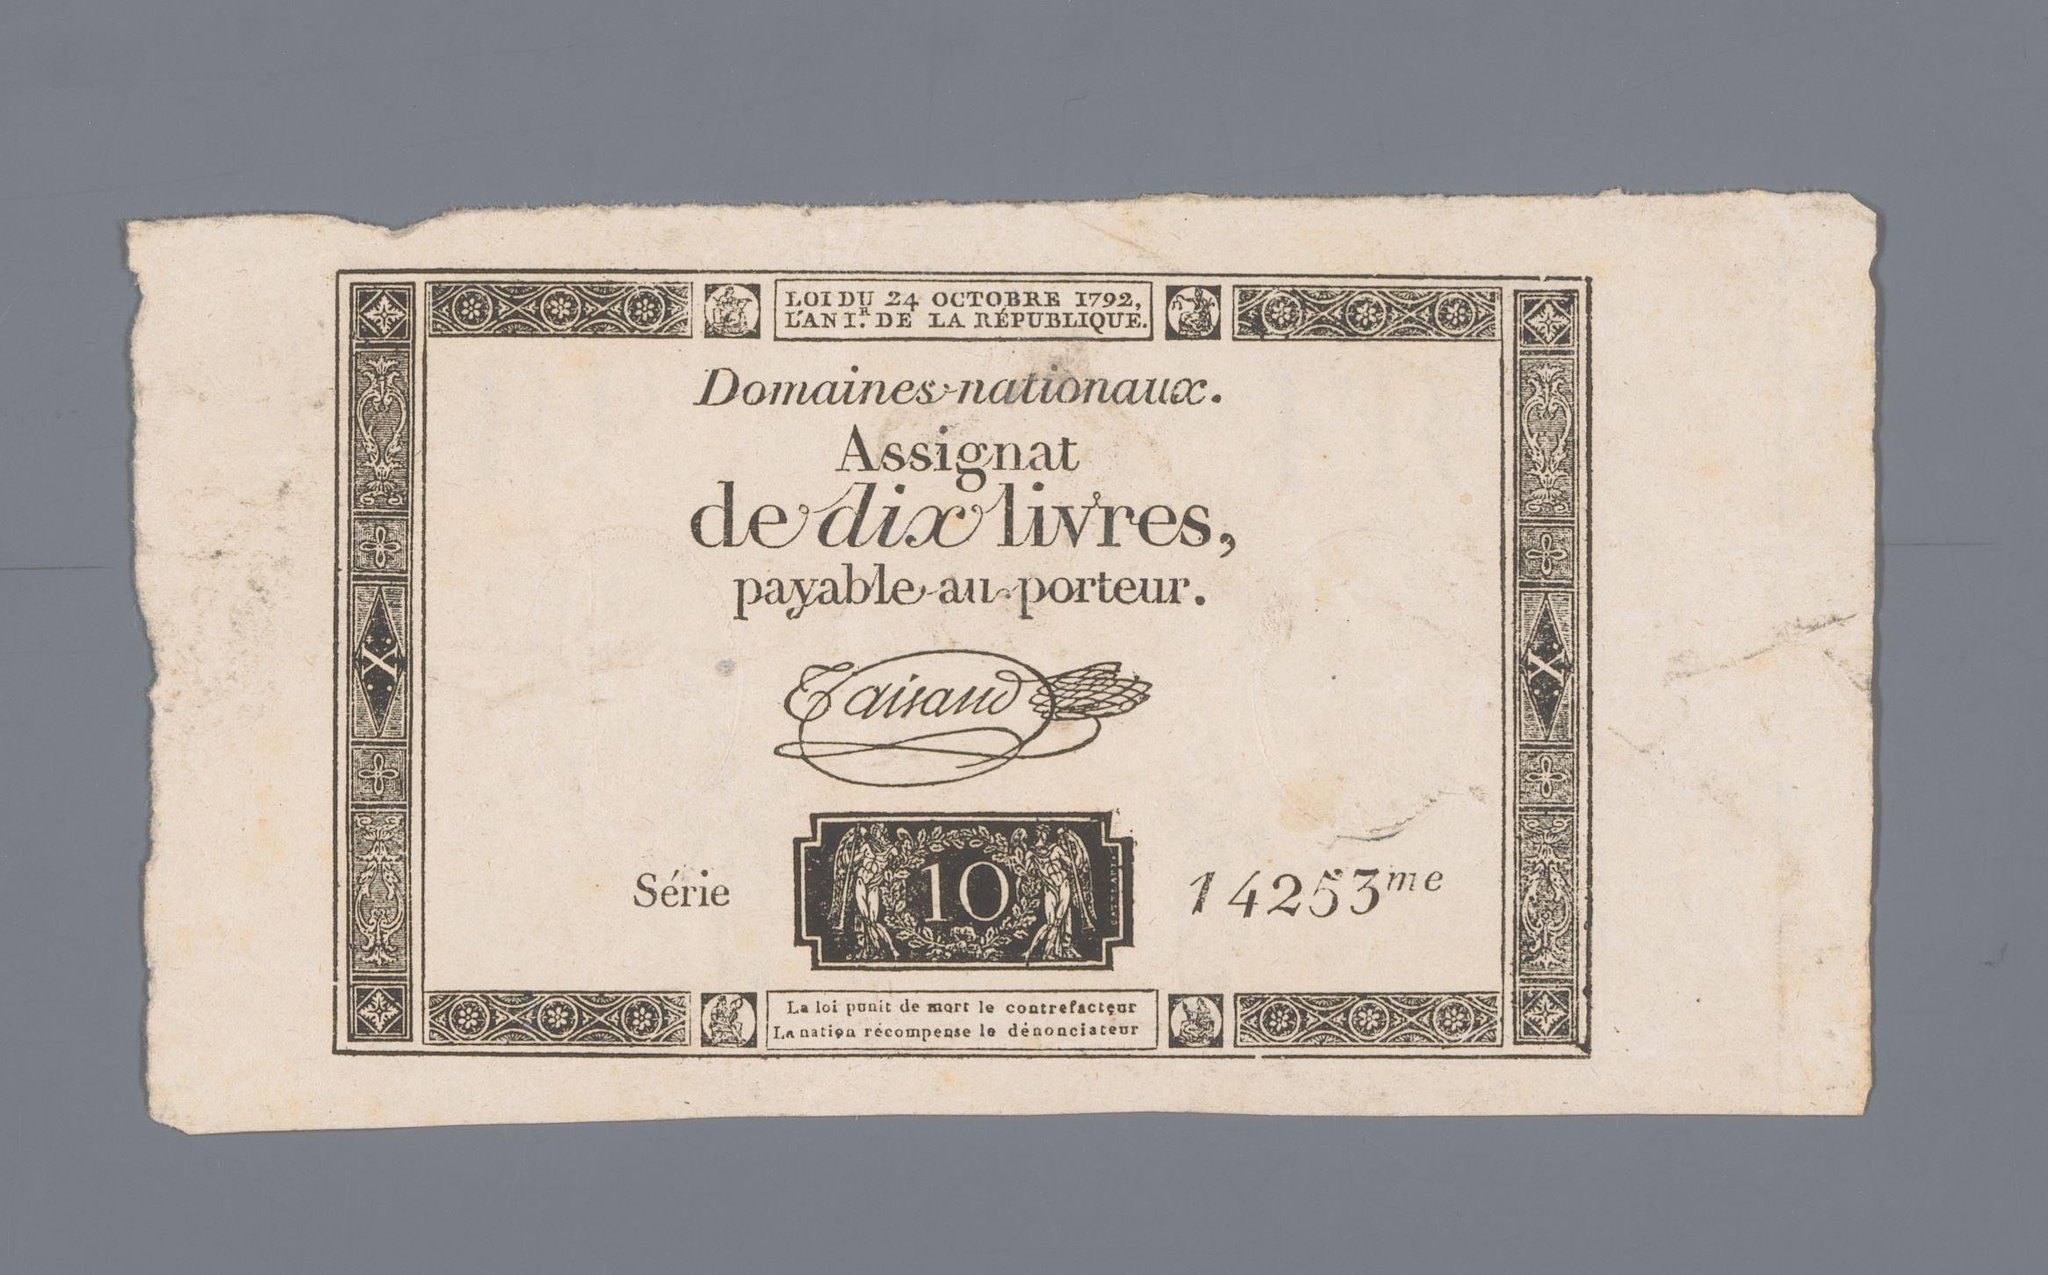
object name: assignat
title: Assignat van tien livres, serie 14253 uitgegeven 24 oktober 1792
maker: Anonymous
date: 1792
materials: paper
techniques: printing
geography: france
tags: bank-note, france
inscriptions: signature: ‘Caisane’